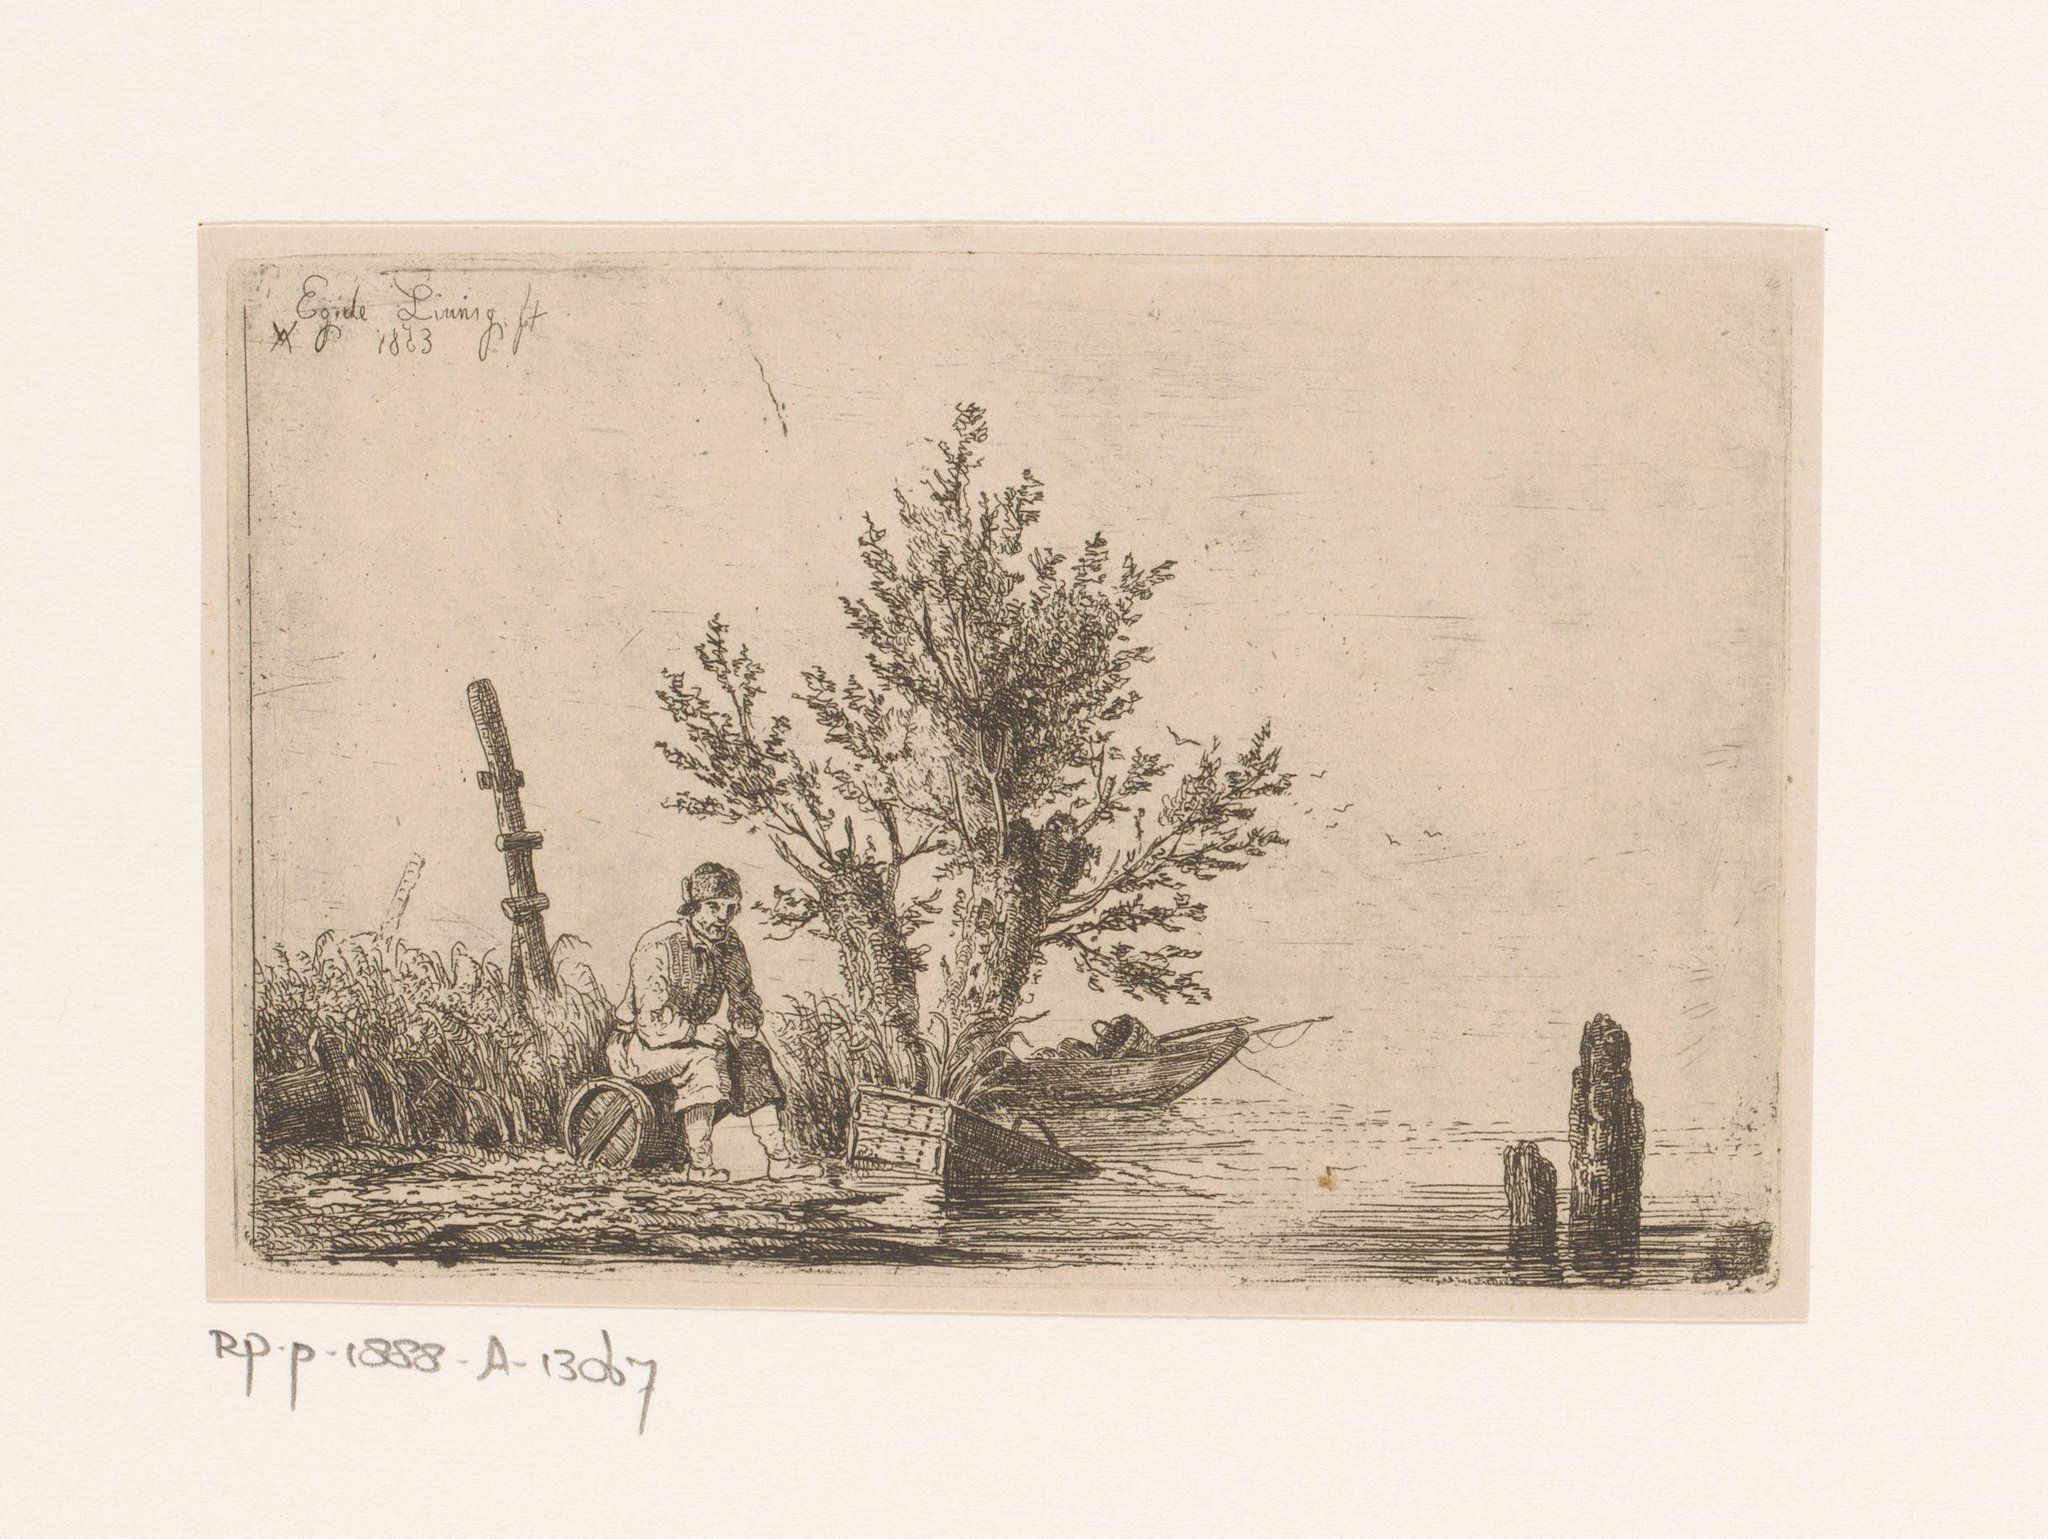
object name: print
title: Visser op een ton aan de waterkant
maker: egidius linnig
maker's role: draughtsman, print maker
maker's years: 1821-1860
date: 1853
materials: paper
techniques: etching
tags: fisherman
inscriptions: collector's mark: Lugt 2228